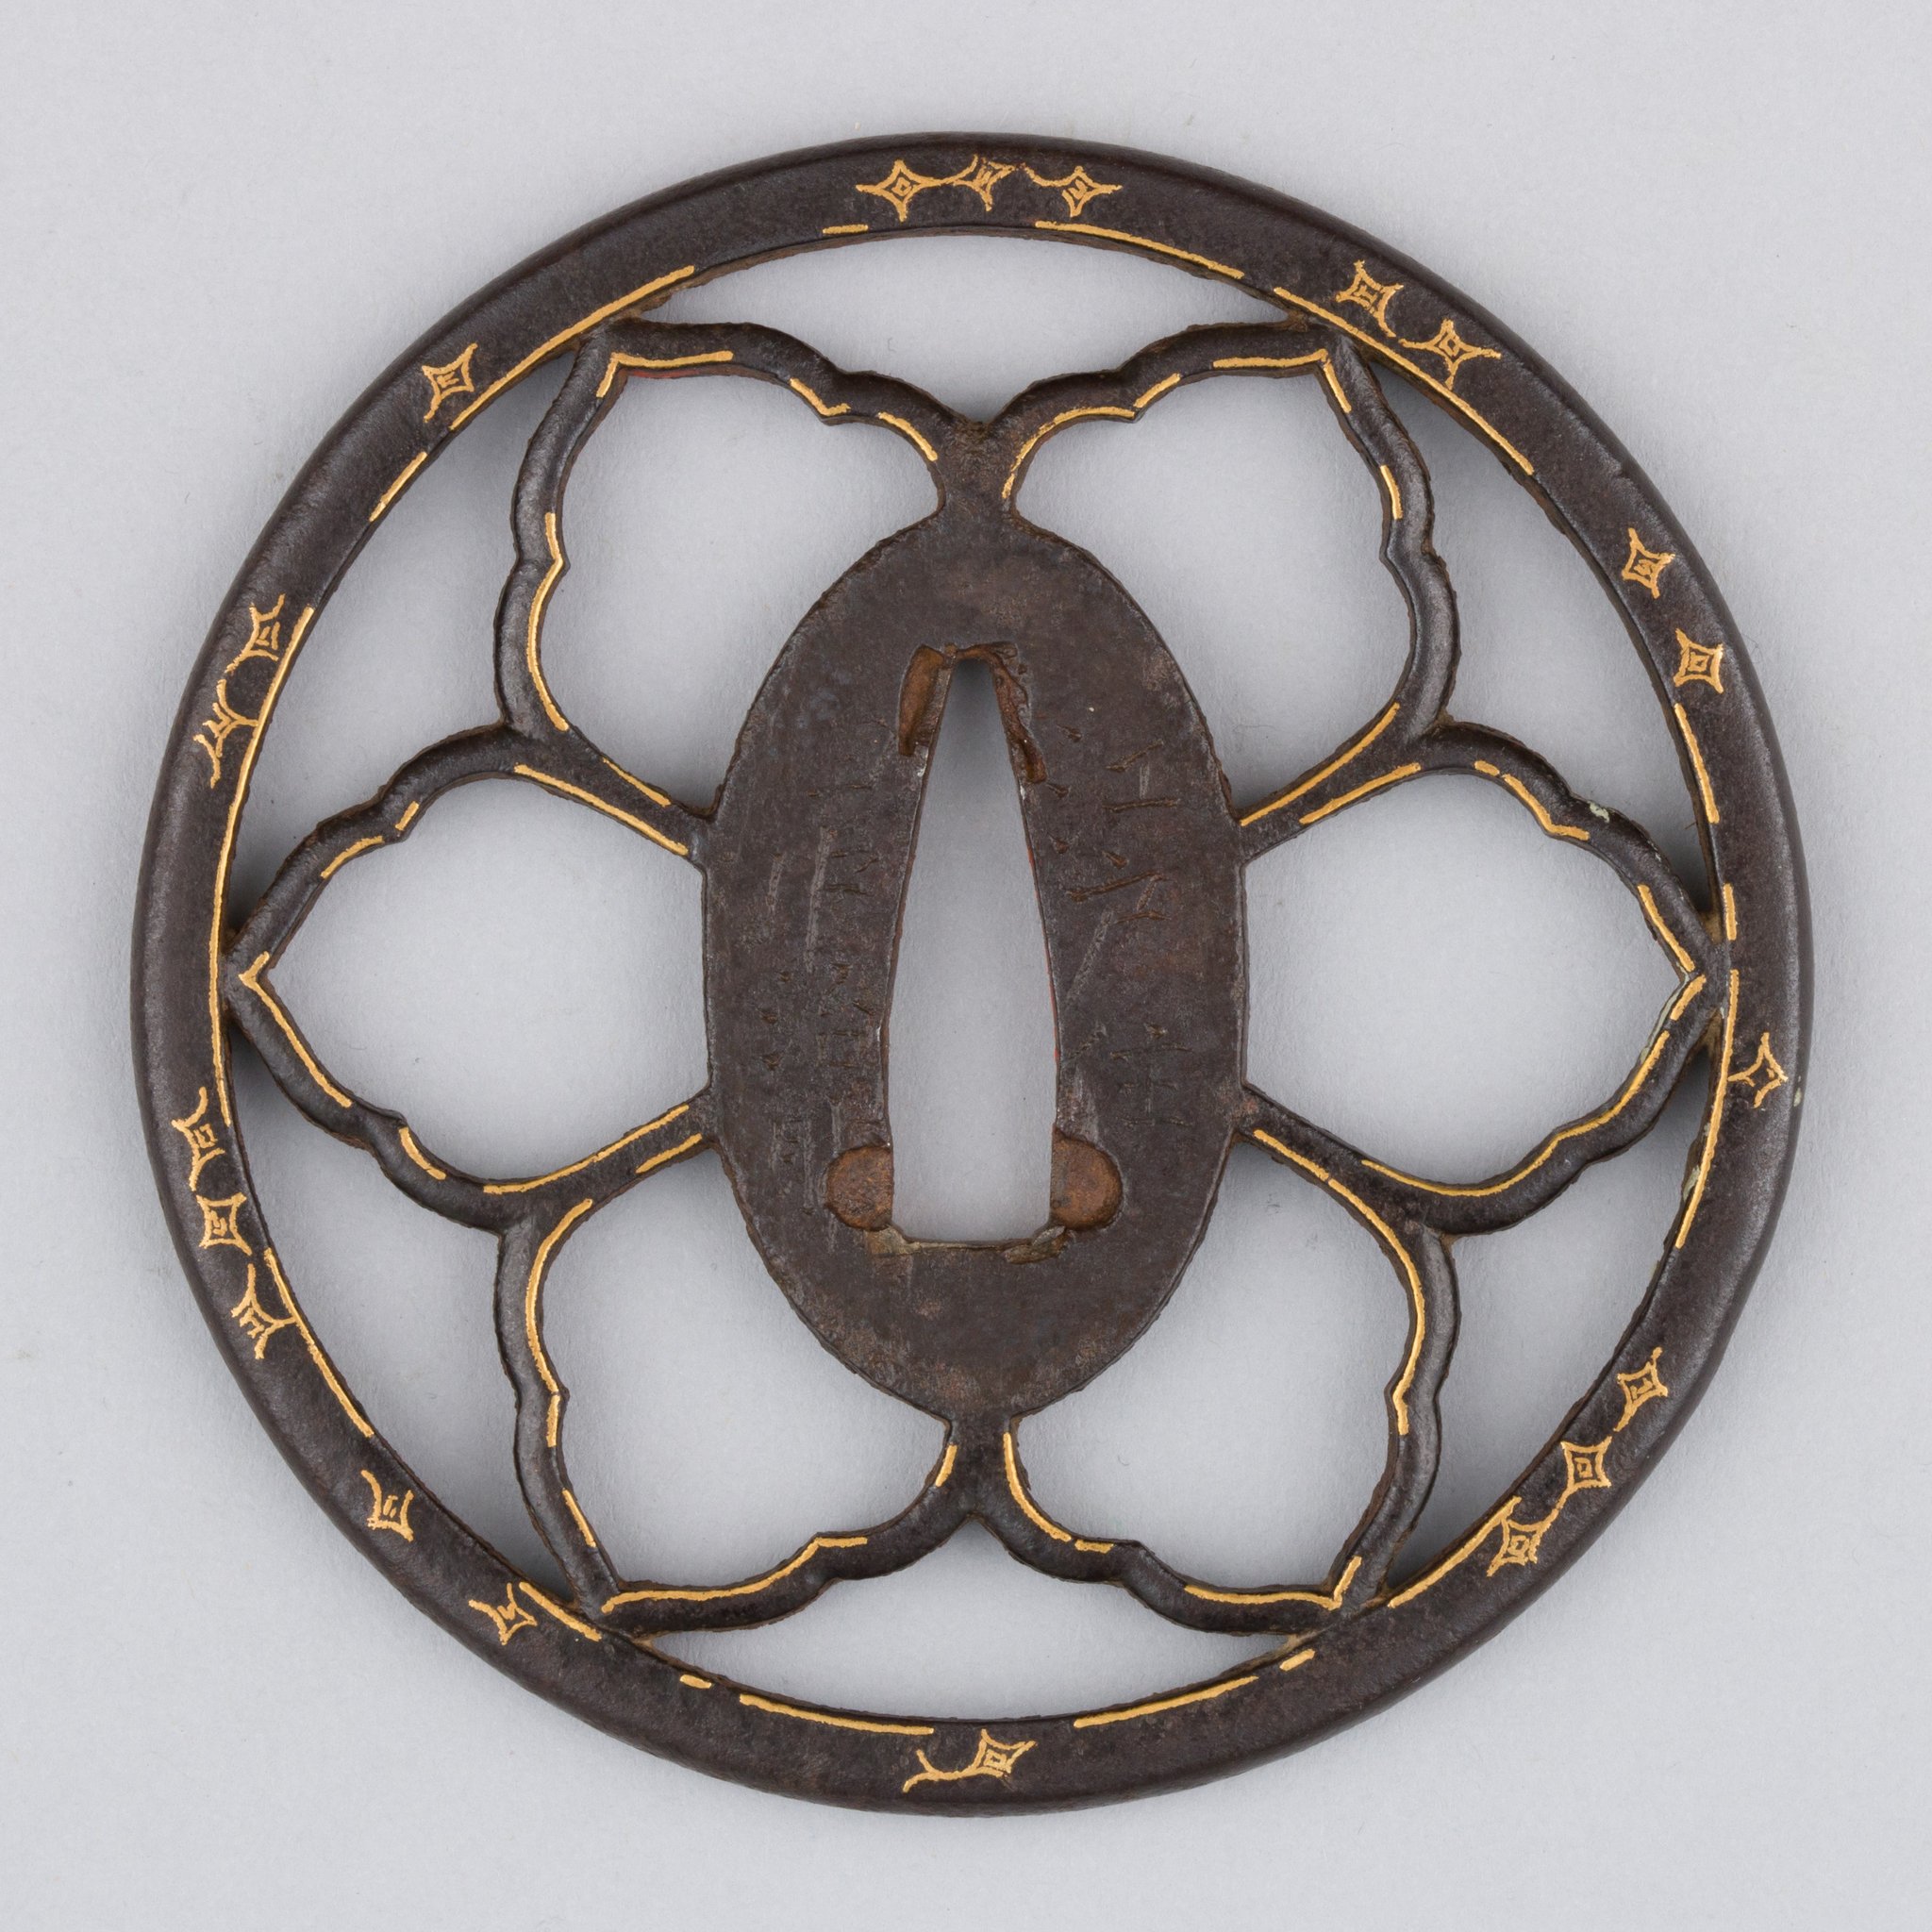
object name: sword guard tsuba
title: Sword Guard (Tsuba)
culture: japanese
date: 1601-1700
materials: copper, gold, iron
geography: japan